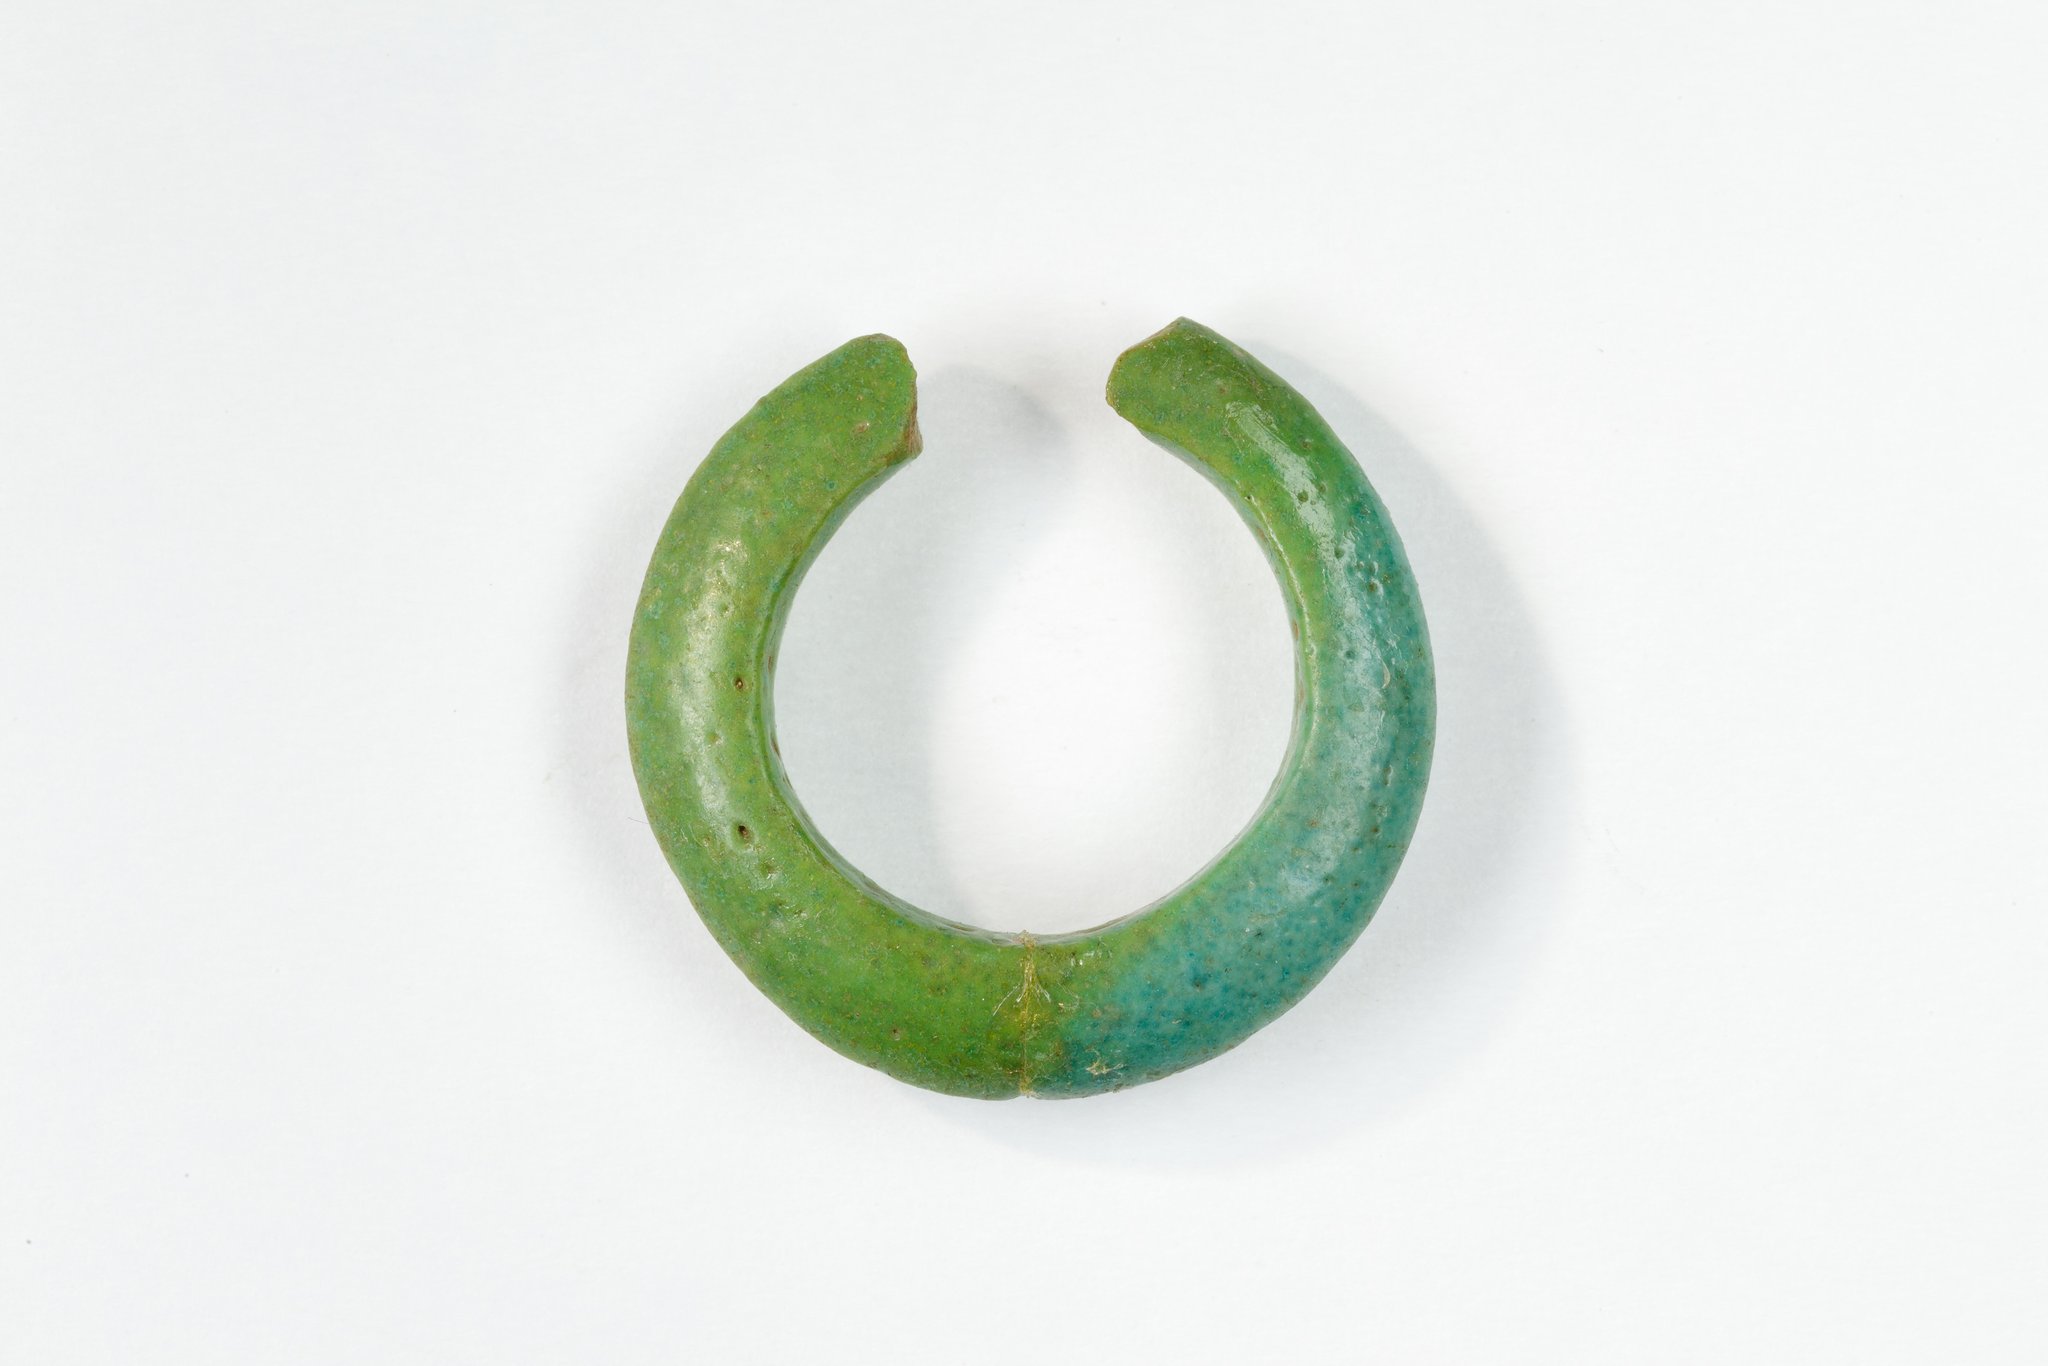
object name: earring, penannular, circular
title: Penannular Earring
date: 1550-1295 BCE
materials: faience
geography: northern upper egypt